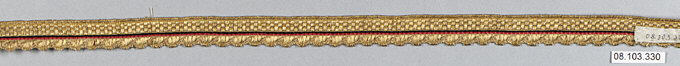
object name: galloon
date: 1801-1900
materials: metal thread, silk